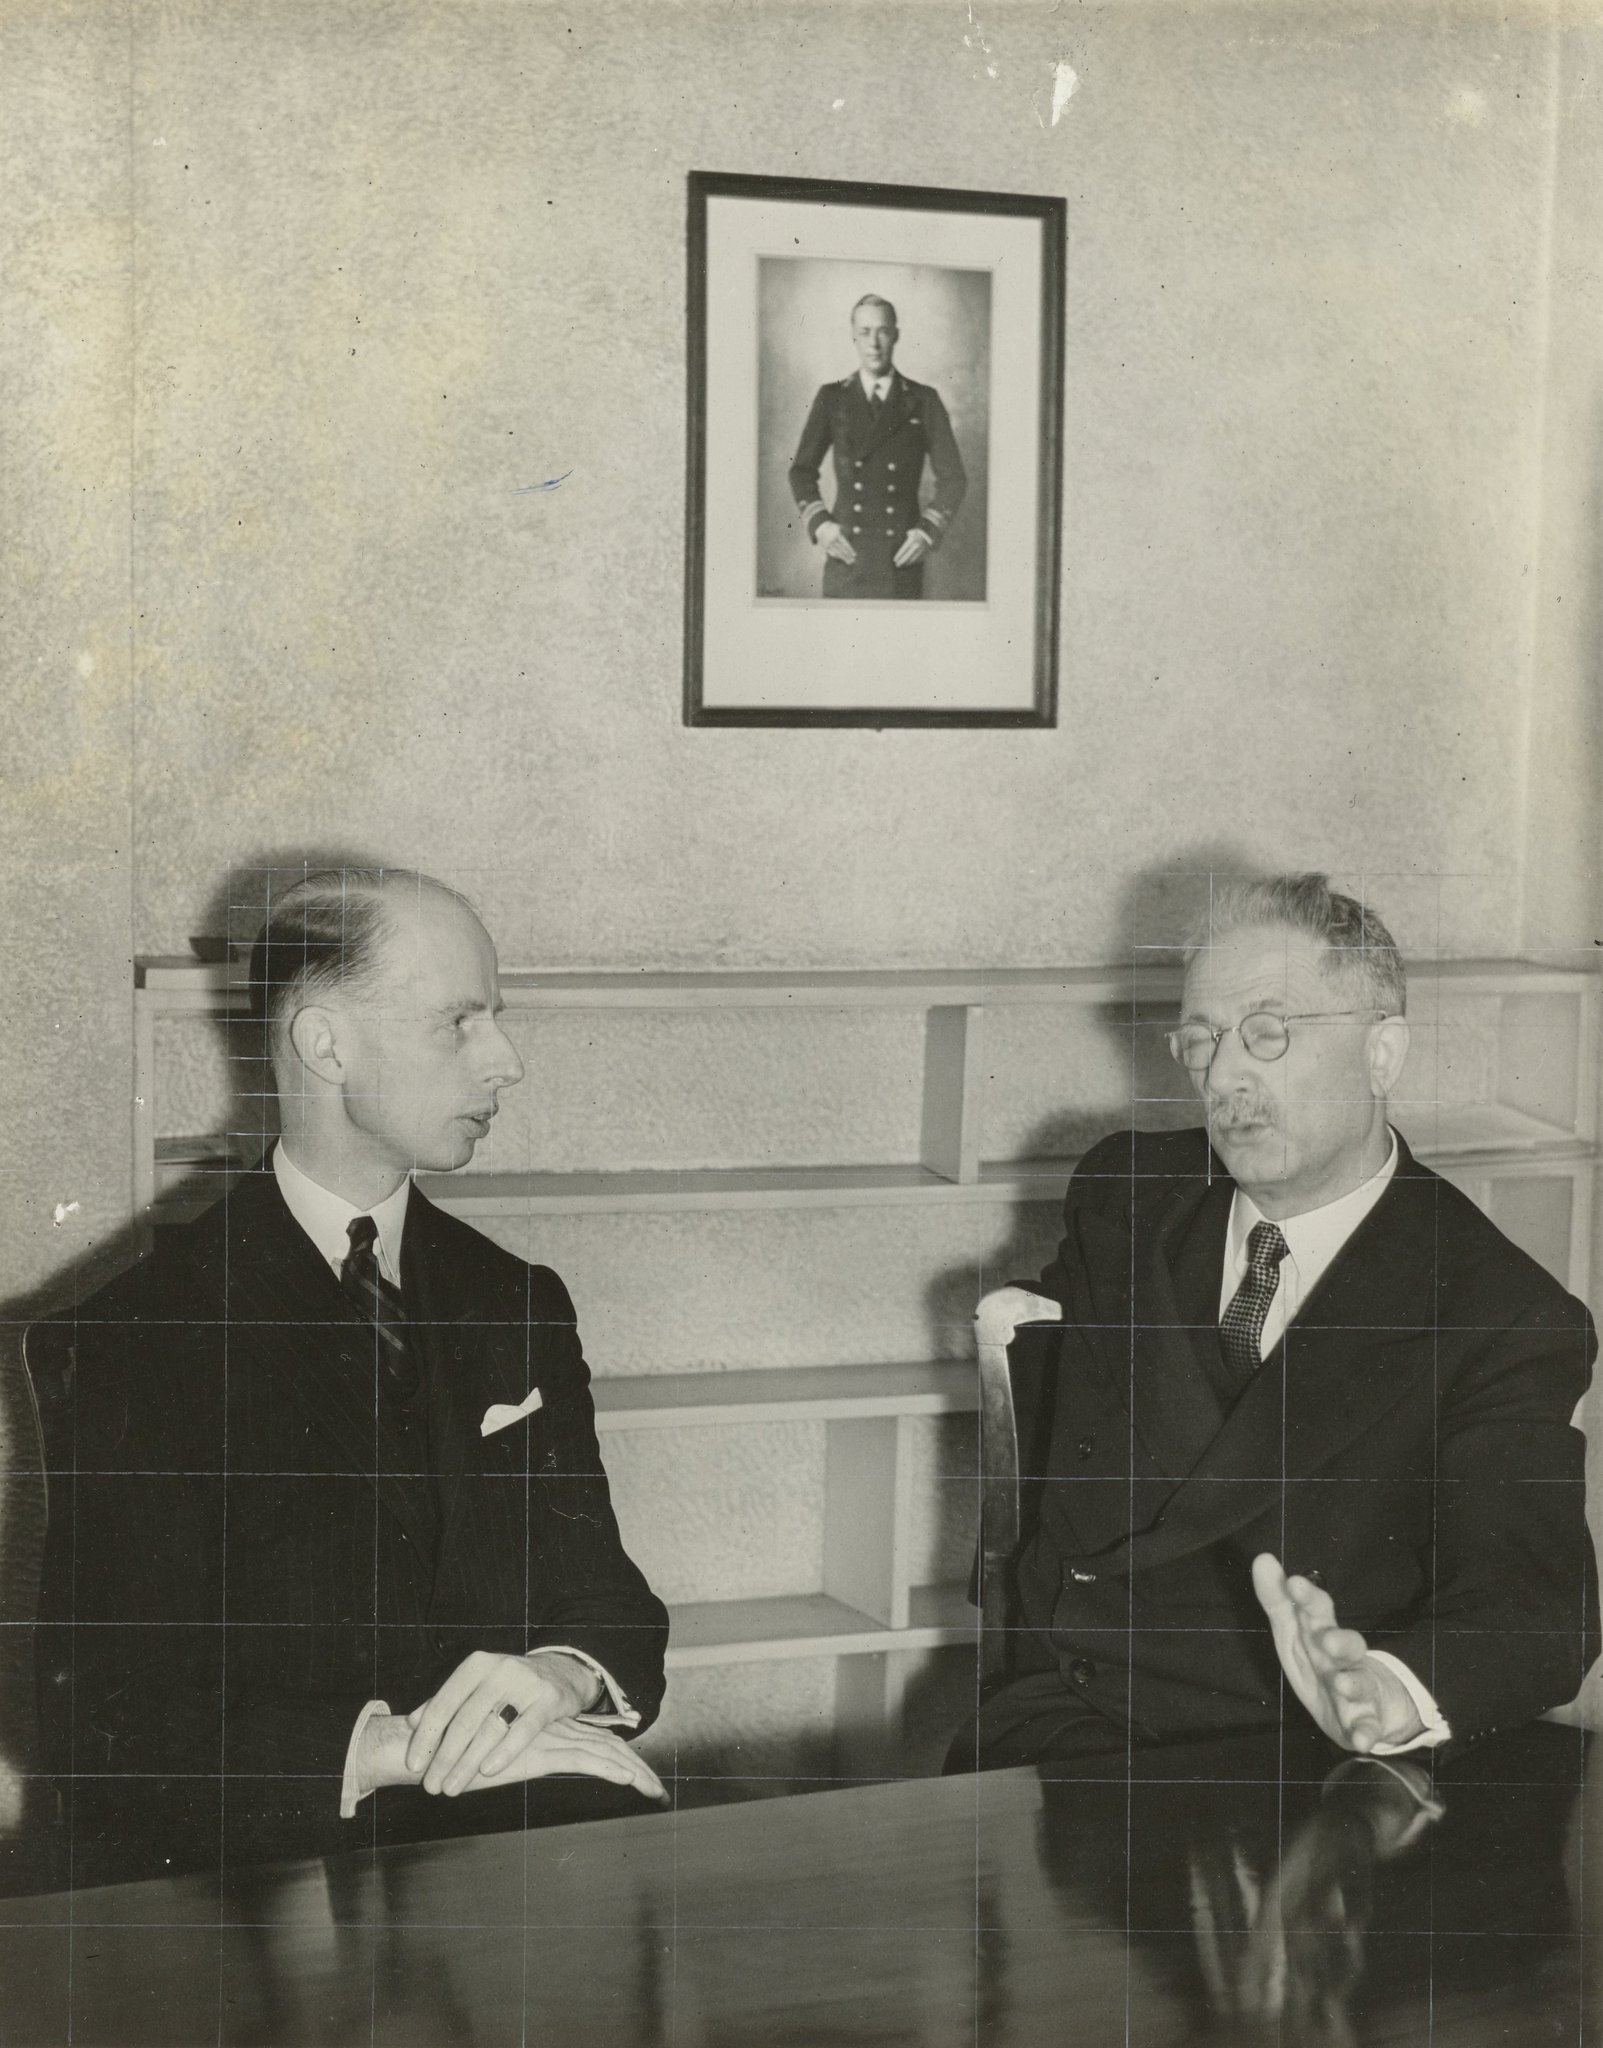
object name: photograph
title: Minister van Kleffens in gesprek met minister Van den Tempel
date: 1940-1945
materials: photographic support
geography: london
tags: politician, london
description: Minister van buitenlandse zaken Eelco van Kleffens (links) in gesprek met minister van sociale zaken Jan van den Tempel (1877-1955). Aan de muur hangt een portret van prins Bernhard. Het lijnennet op de foto is aangebracht door kunstenaar Cor Visser.